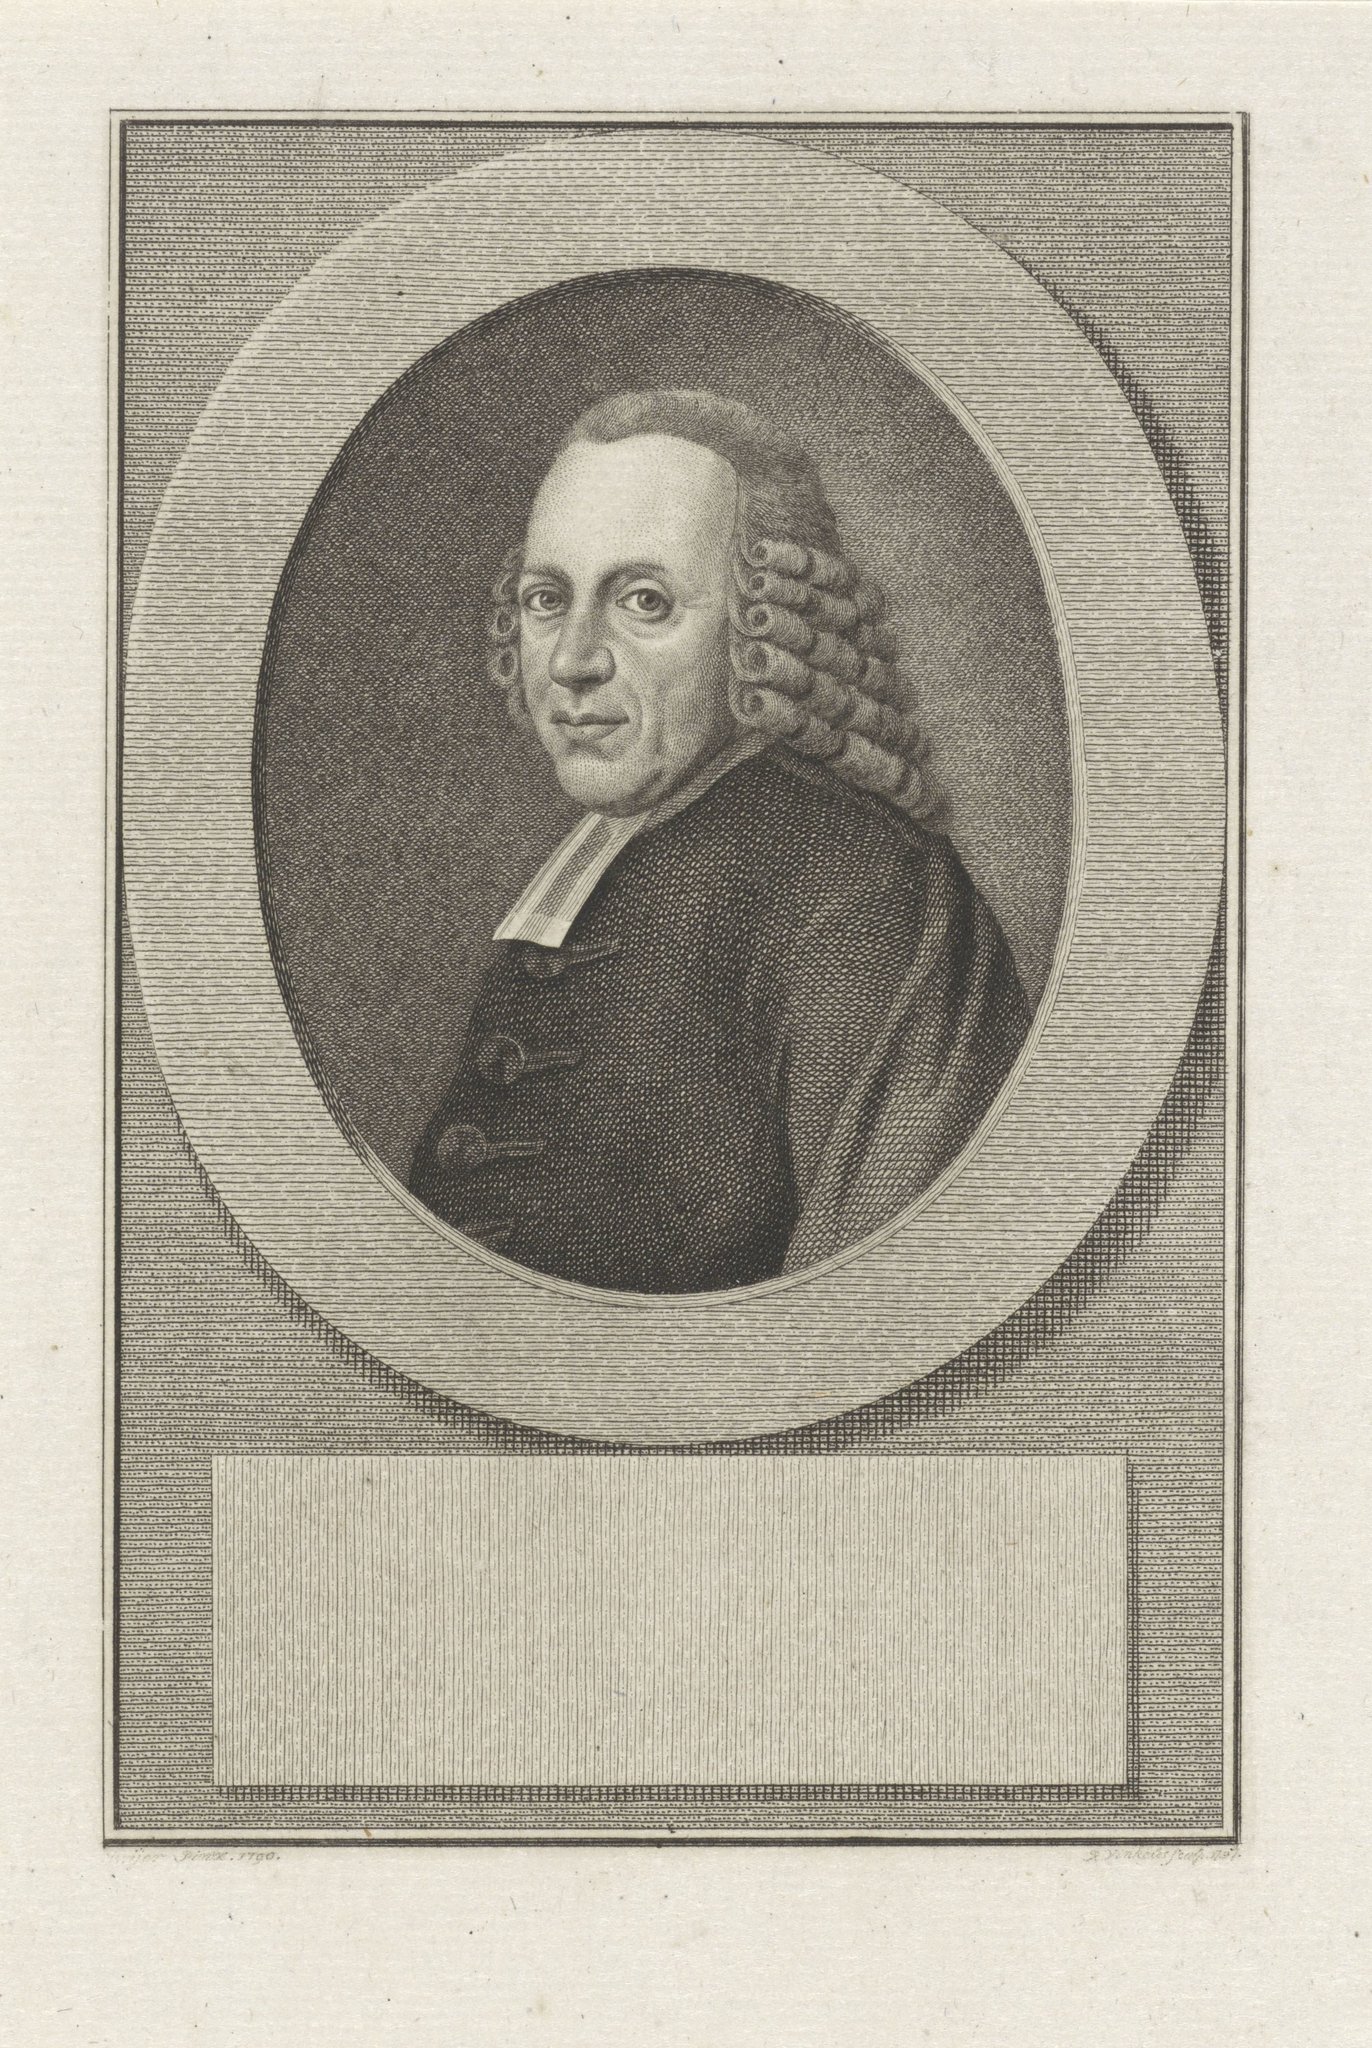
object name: print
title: Portret van Henricus van Herwerden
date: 1797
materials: paper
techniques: engraving, etching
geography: amsterdam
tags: predikant, henricus van herwerden (i)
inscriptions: collector's mark: Lugt 2228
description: Portret van de Amsterdamse predikant Henricus van Herwerden.